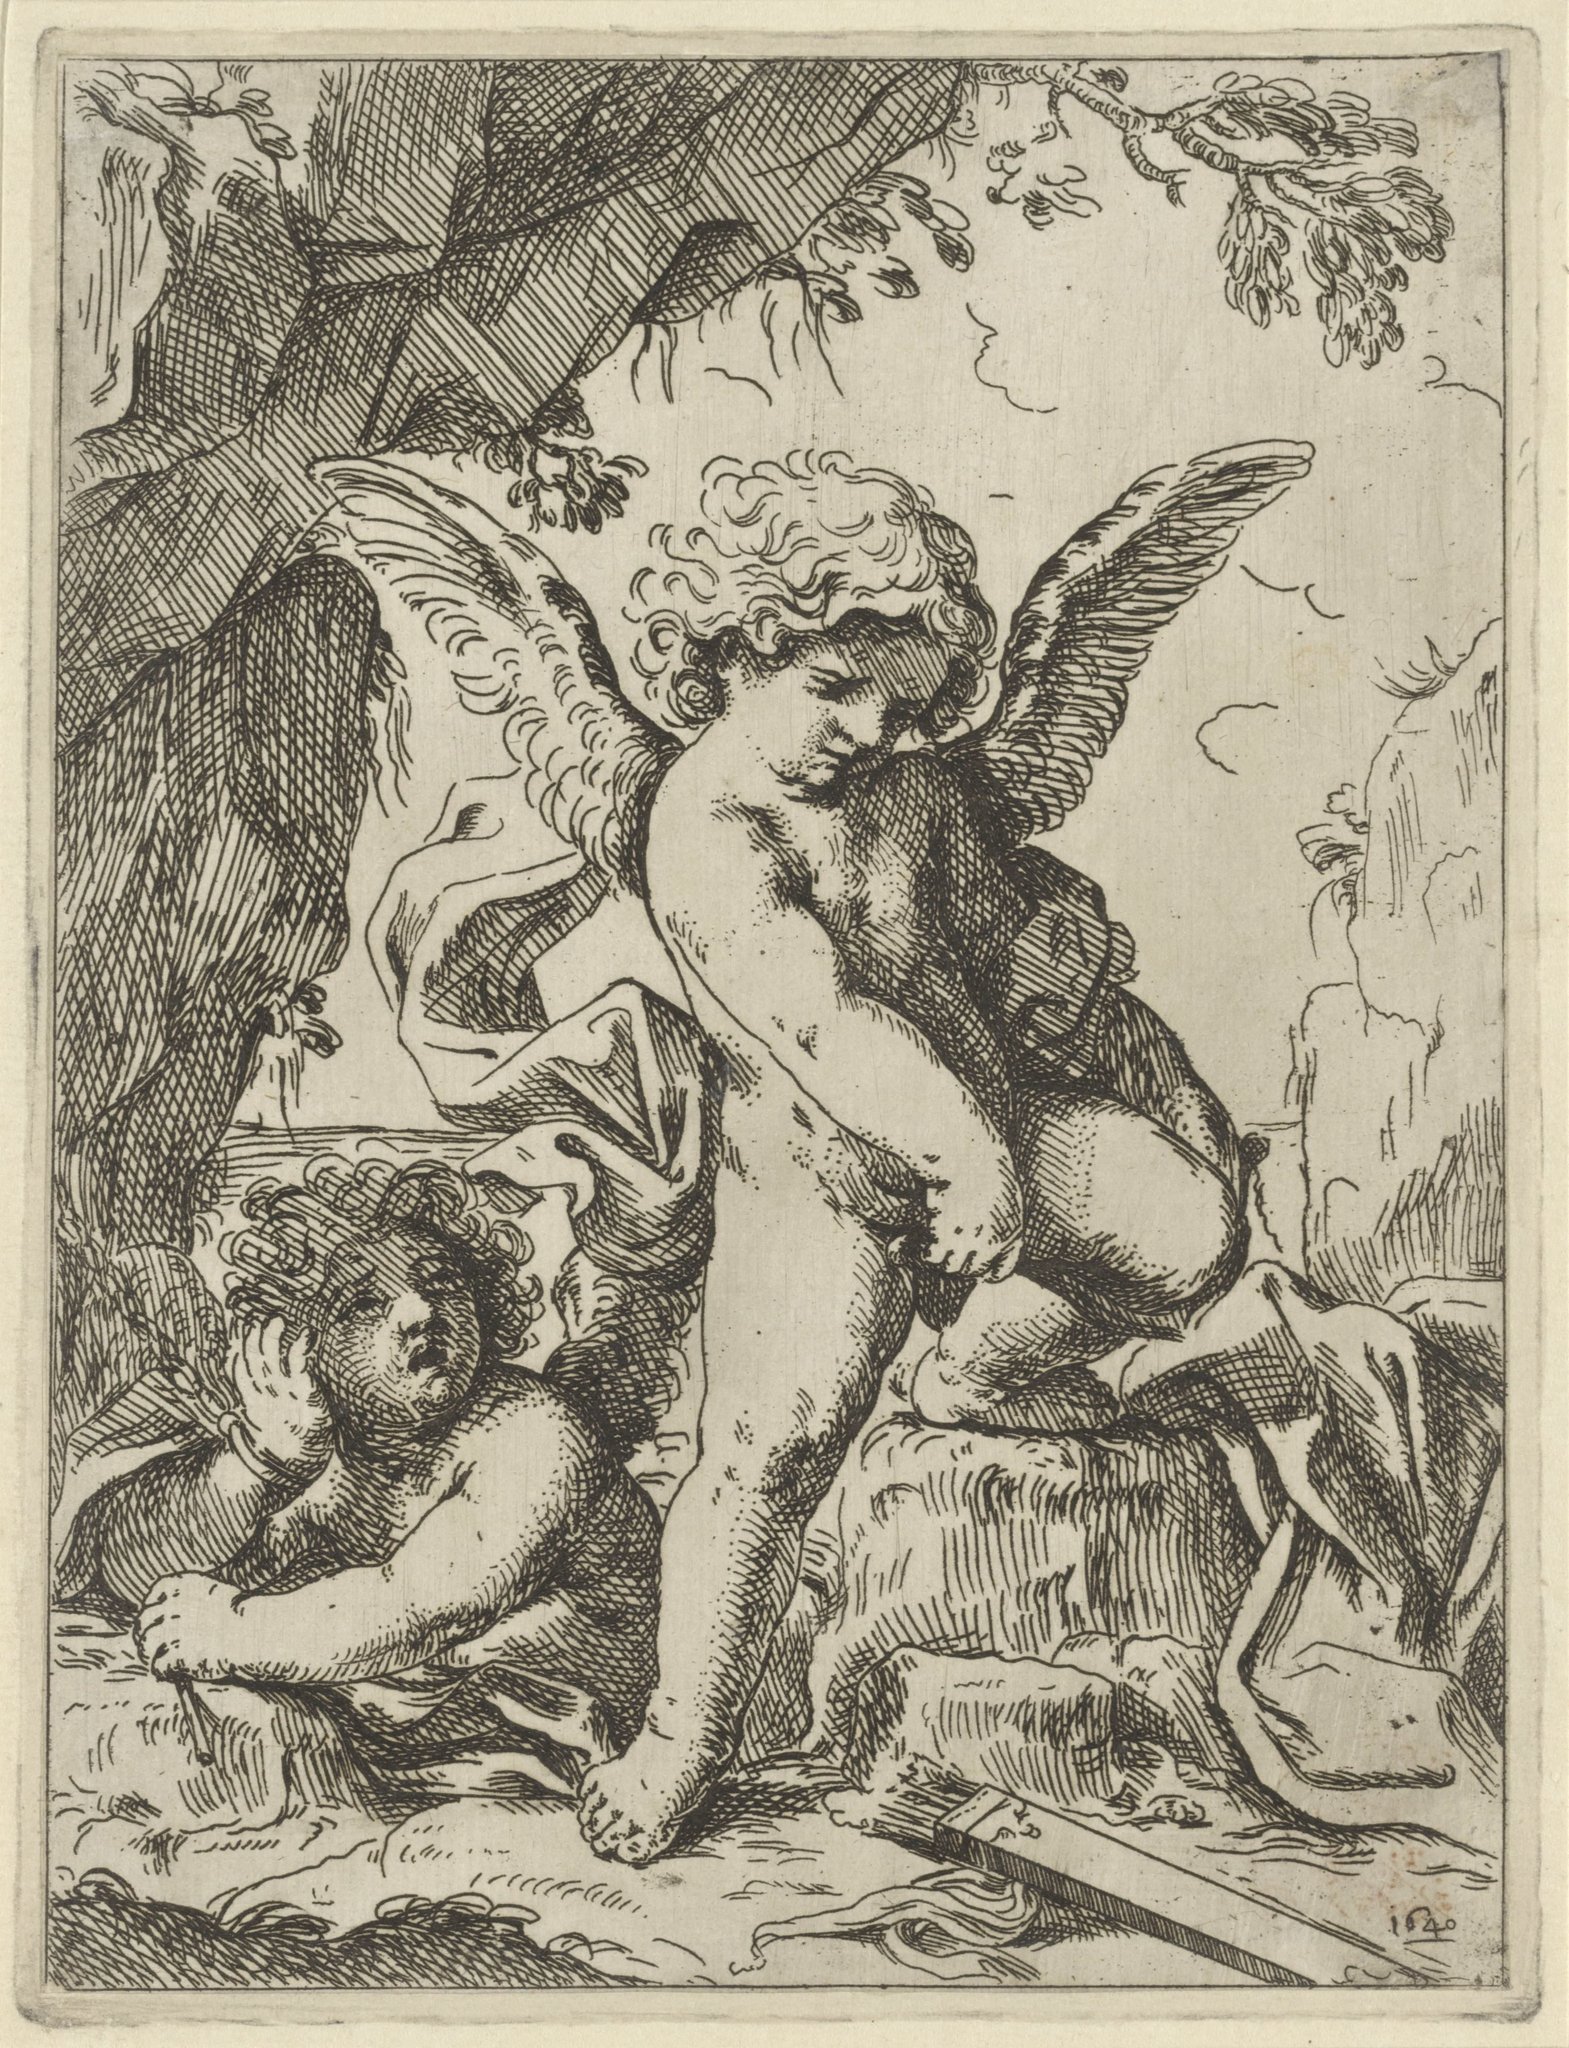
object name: print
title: Amor breekt zijn boog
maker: lorenzo loli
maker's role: print maker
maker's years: 1612-1691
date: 1640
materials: paper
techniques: etching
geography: italy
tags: (story of) cupid, amor (eros), cupid breaking his bow and/or arrows, cupids: 'amores', 'amoretti', 'putti'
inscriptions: collector's mark: Lugt 240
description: Amor breekt zijn boog over zijn knie. Een putto ligt verslagen op de grond, geketend aan een rotswand. Op de voorgrond liggen de pijlen van Amor.